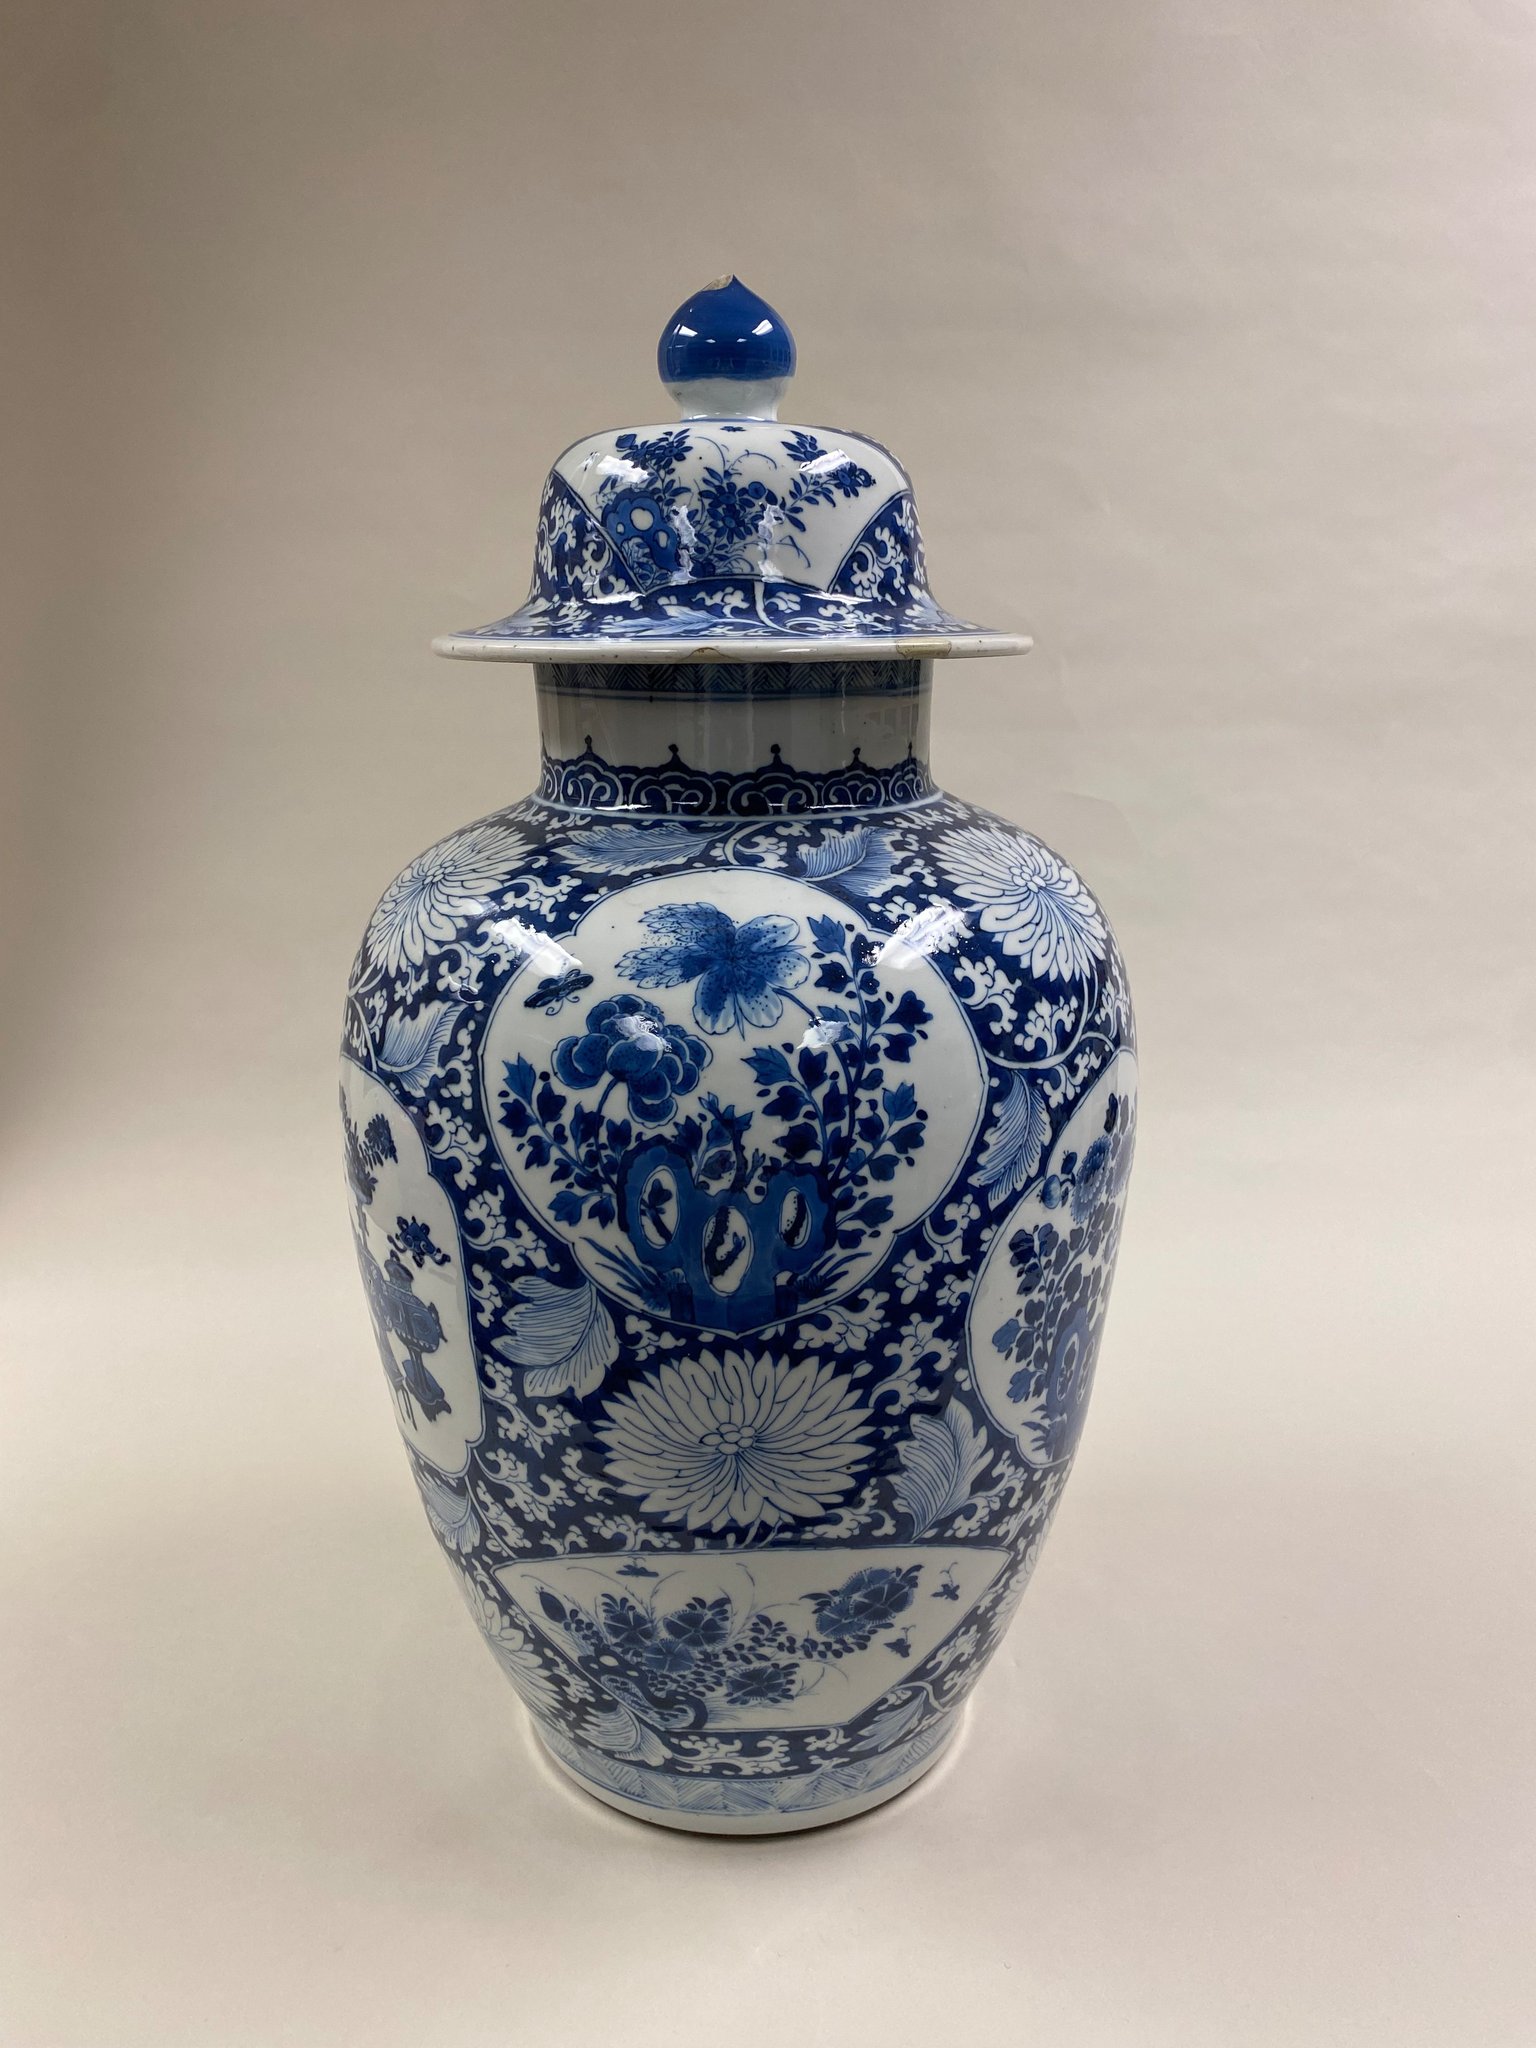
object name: covered jar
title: Covered jar with floral patterns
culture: chinese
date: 1667-1733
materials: cobalt, porcelain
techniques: painting, underglaze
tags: flowers